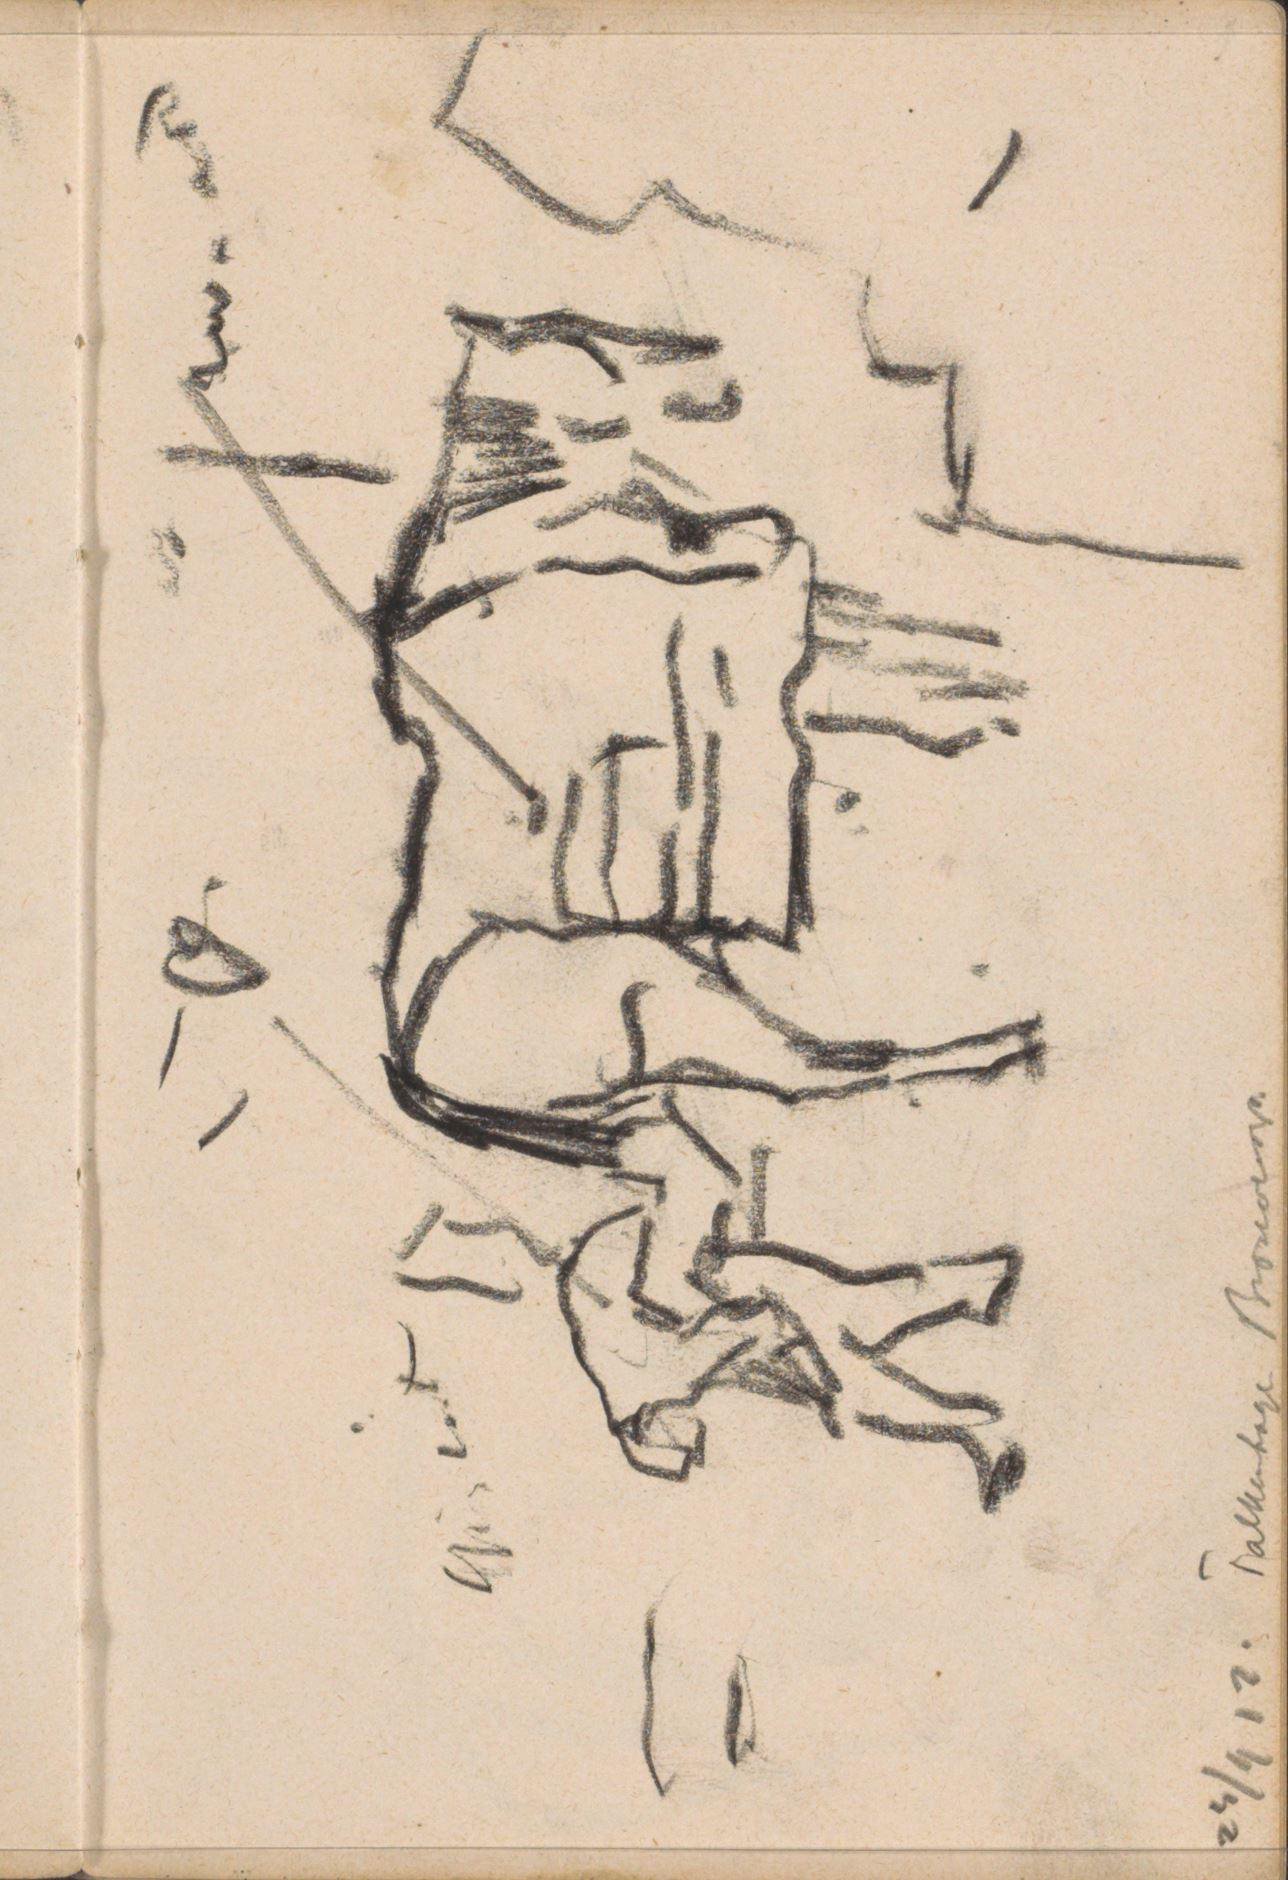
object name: sketchbook leaf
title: Hoefsmid aan het werk bij Falkenhagen aan de Brouwersgracht te Amsterdam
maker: george hendrik breitner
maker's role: draughtsman, painter, print maker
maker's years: 1857-1923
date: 1912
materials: chalk, paper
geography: amsterdam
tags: farrier, shoeing-smith, adult man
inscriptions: annotation: ‘Falkenhagen Brouwersgr.’, date: ‘24/9 12.’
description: Hoefsmid beslaat een paard bij Hoefsmederij Falkenhagen aan de Brouwersgracht 32 te Amsterdam. Pagina 18 uit een schetsboek met 46 bladen vervaardigd te Amsterdam.